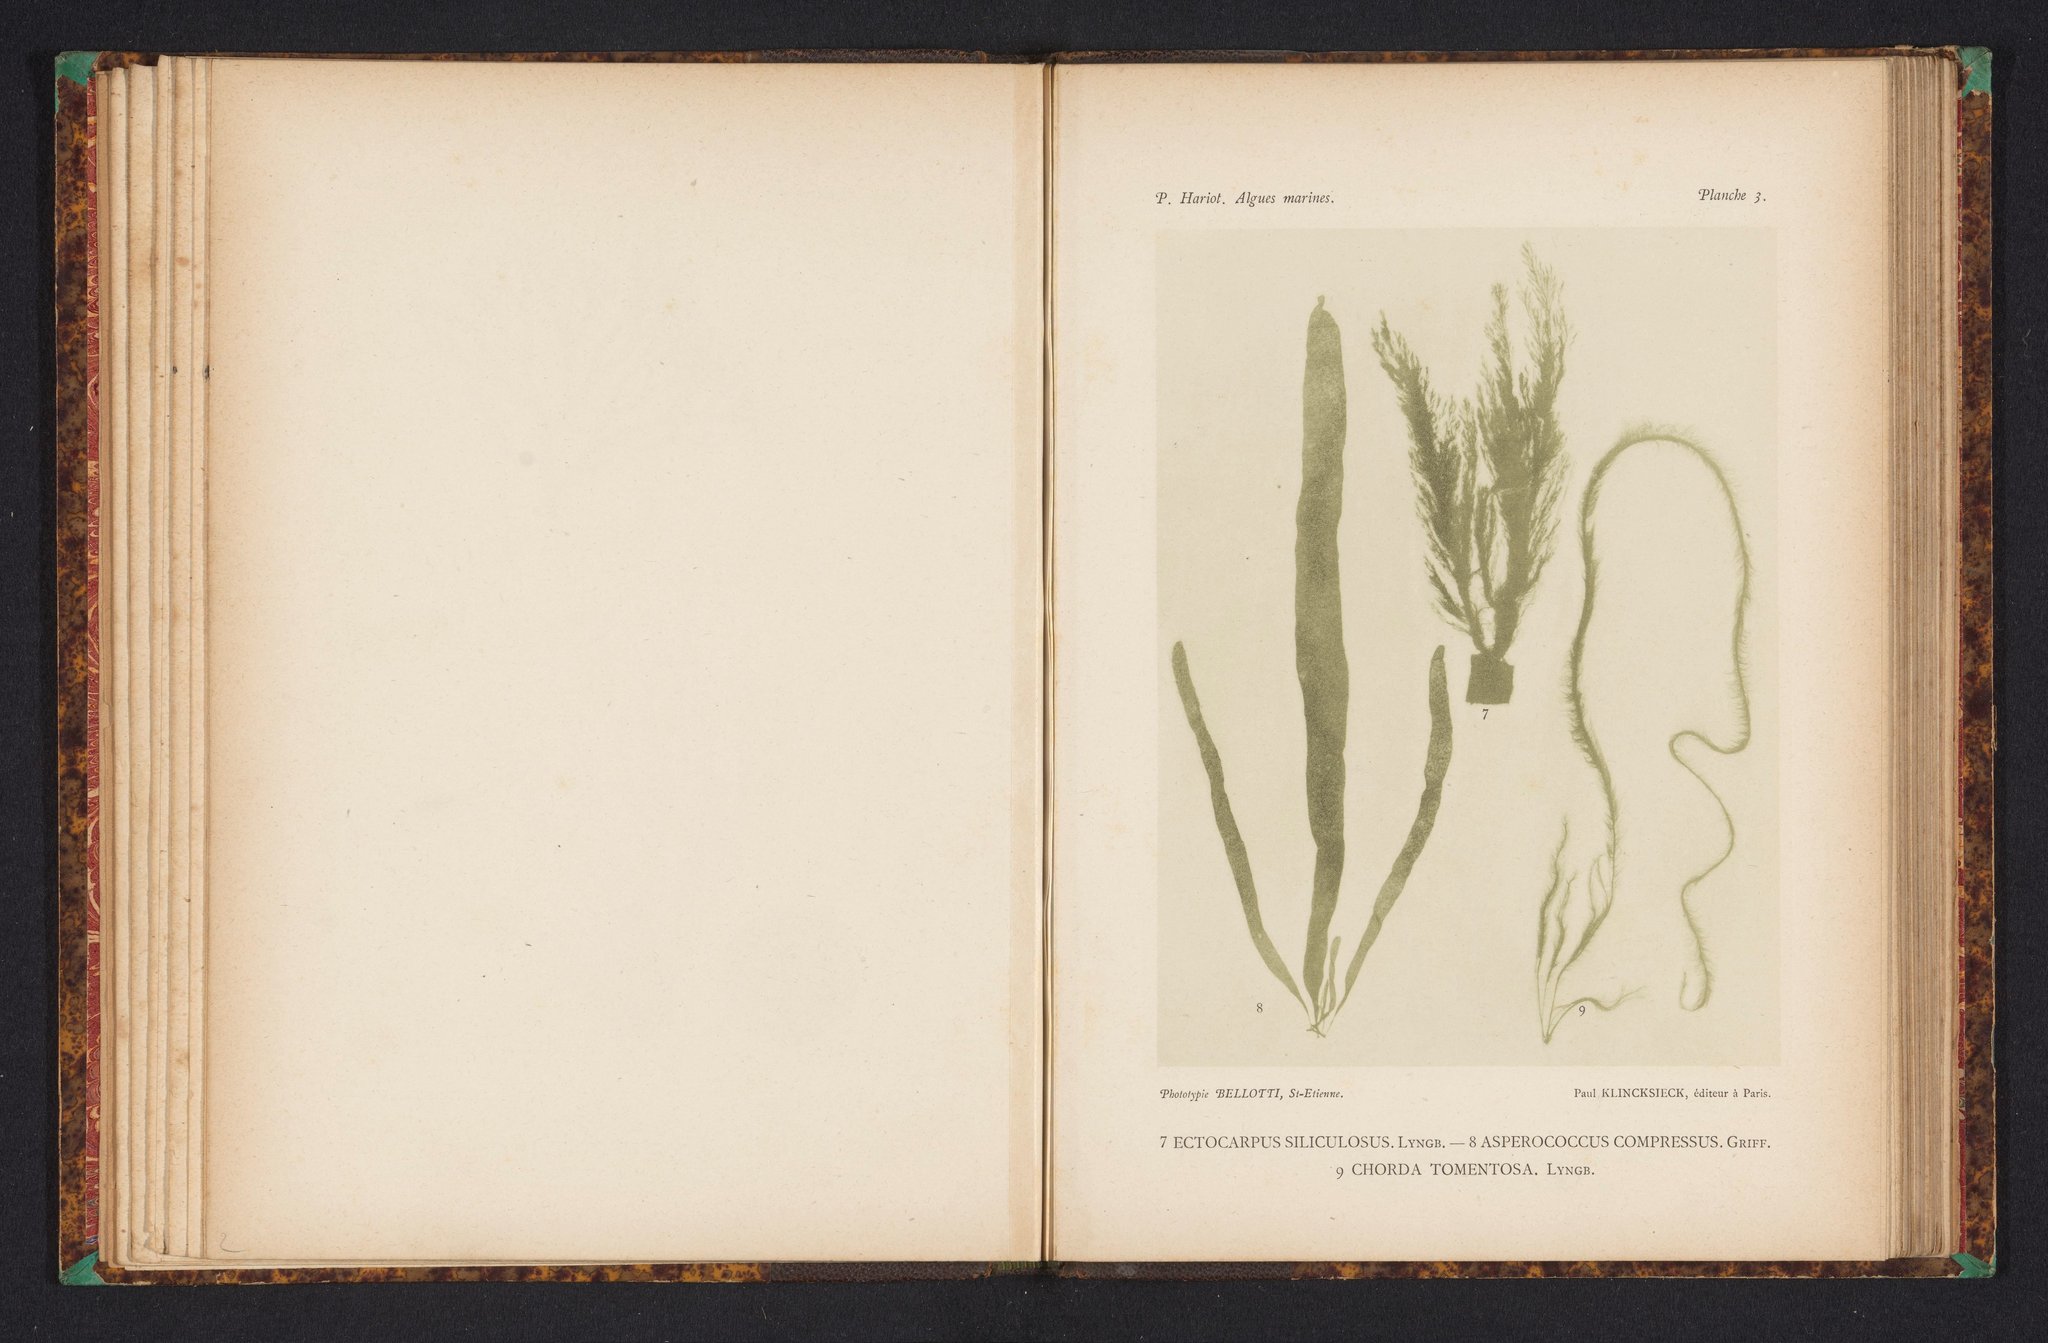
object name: photomechanical print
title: Drie soorten zeewier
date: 1882-1892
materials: paper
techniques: photograph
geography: france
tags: algae, seaweed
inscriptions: inscription: ‘7 Ectocarpus siliculosus (...) chorda tomentosa. Lyngb.’, number: ‘7 (...) 9’, number: ‘Planche 3.’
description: (7) is kwastwier, (8) is bruinwier (9) is bruinwier.